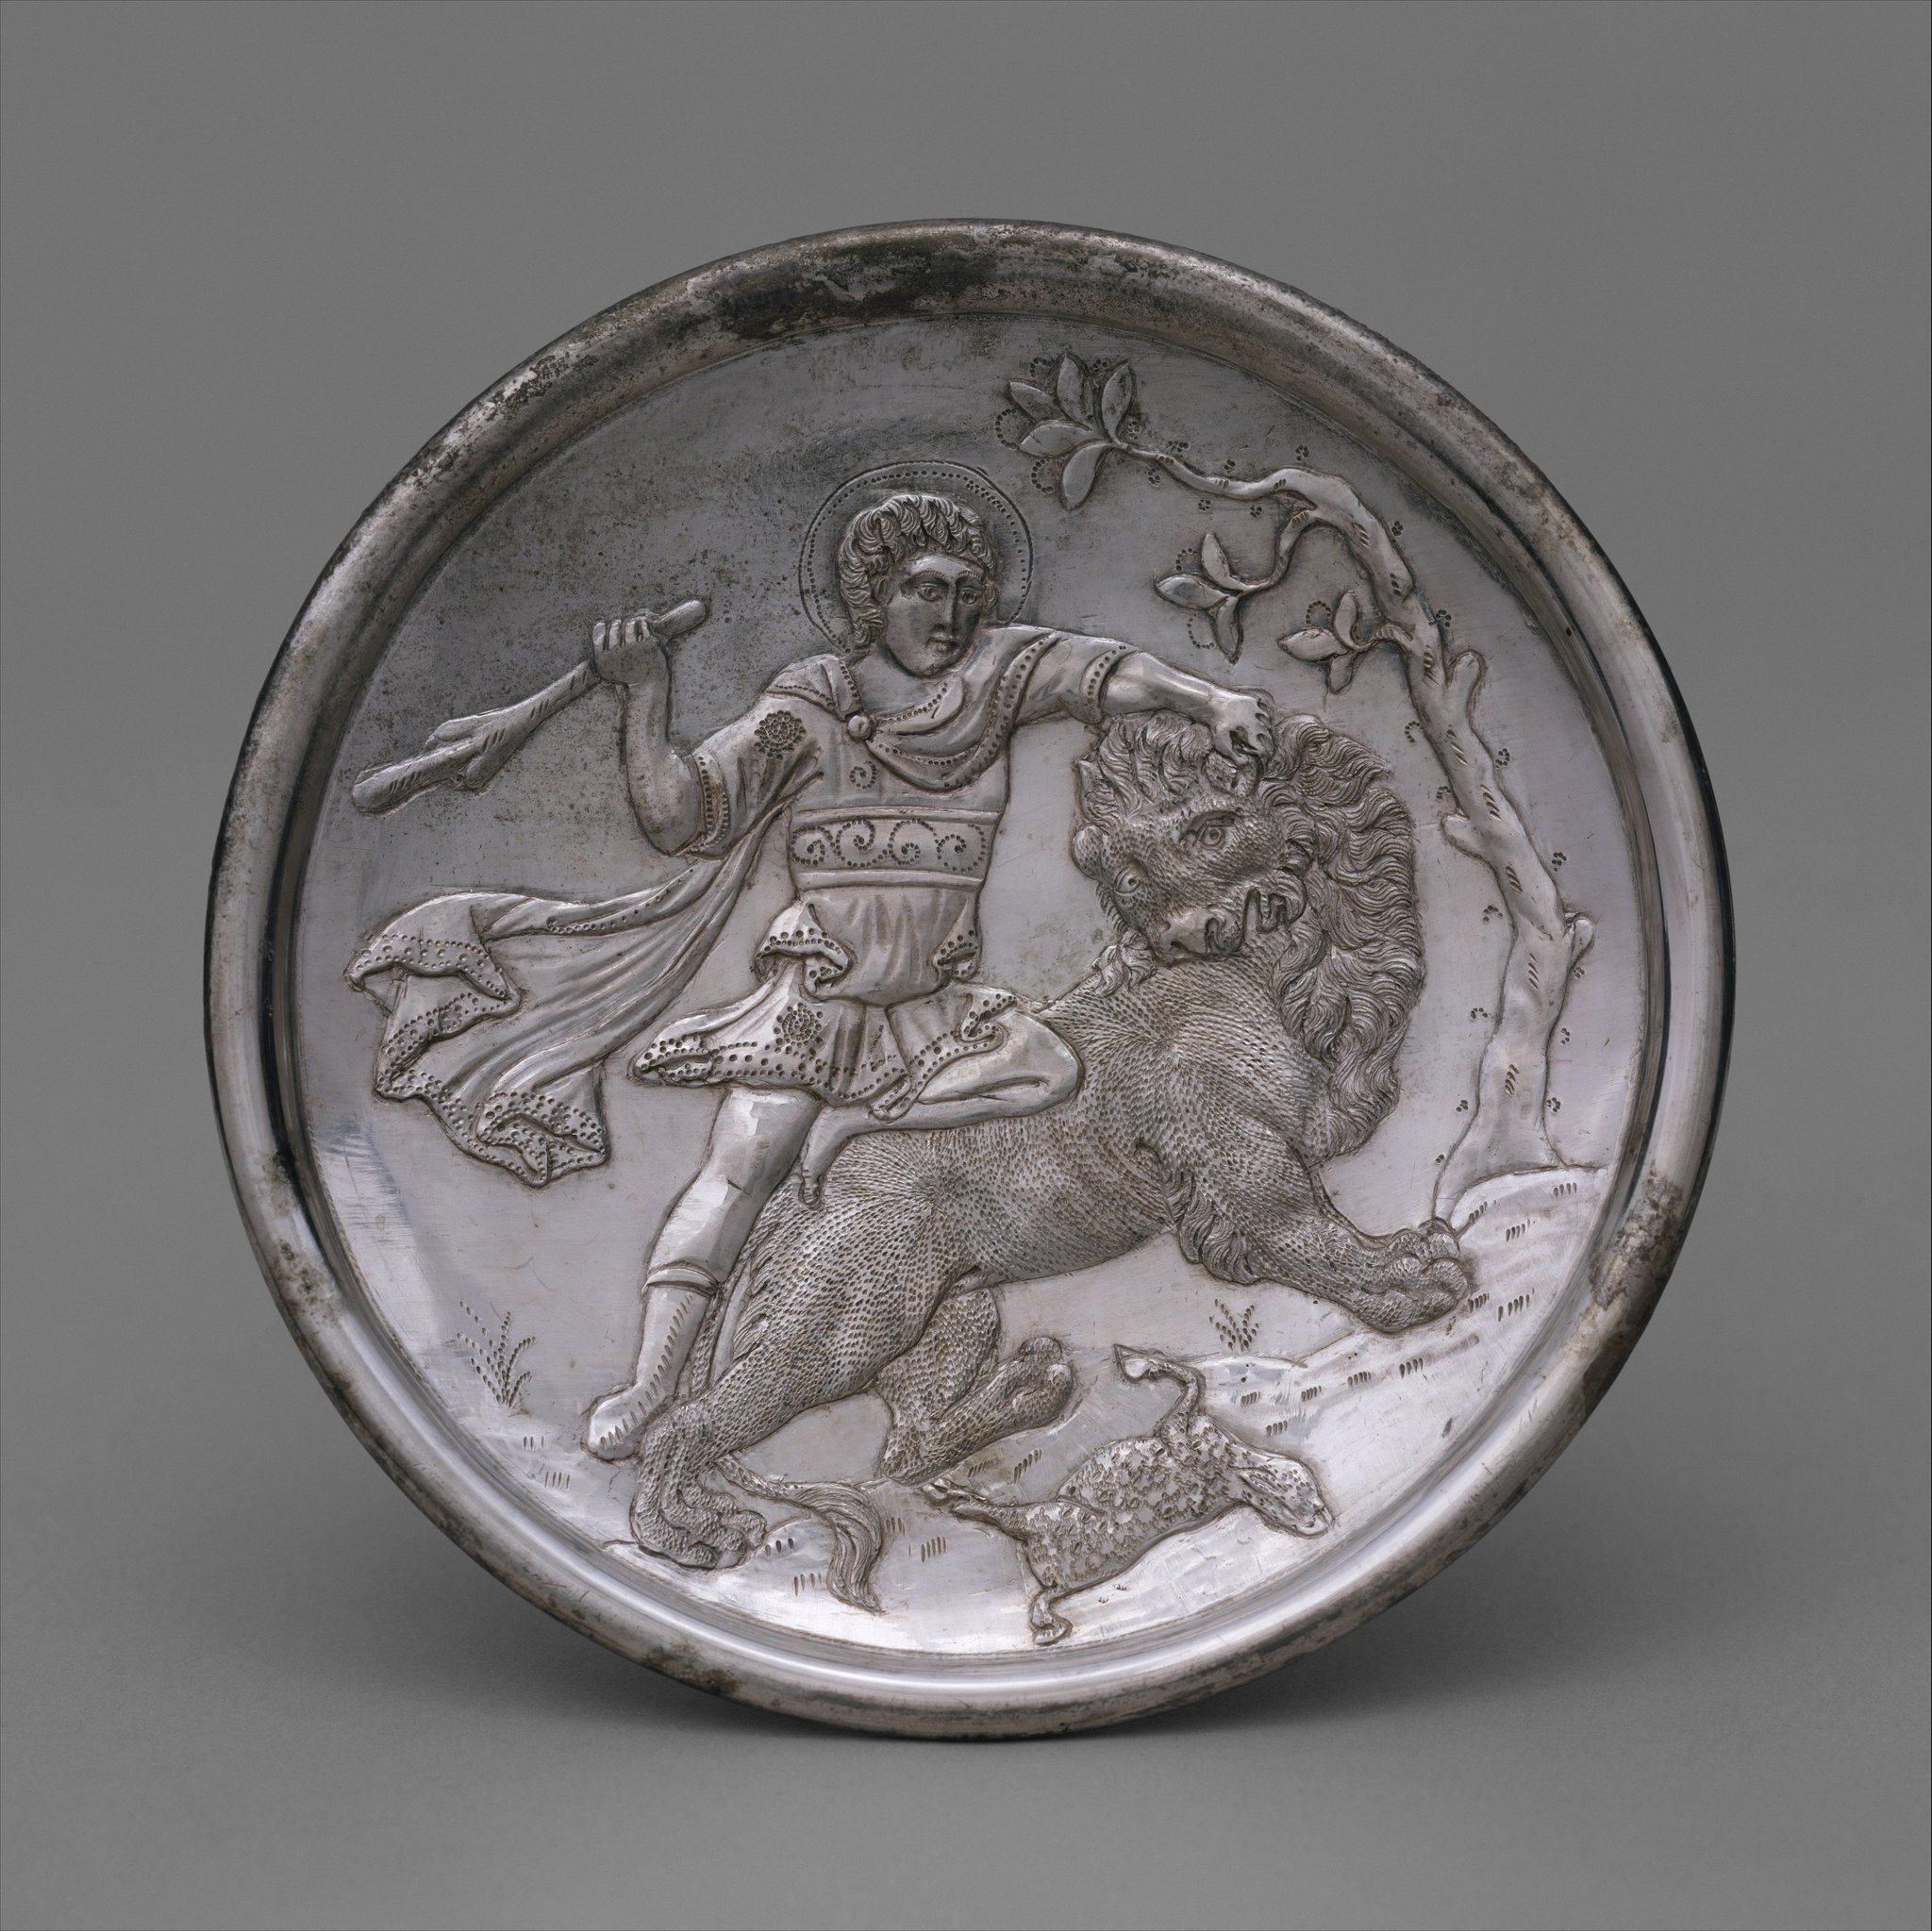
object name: plate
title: Plate with David Slaying a Lion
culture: byzantine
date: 629-630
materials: silver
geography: constantinople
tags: david